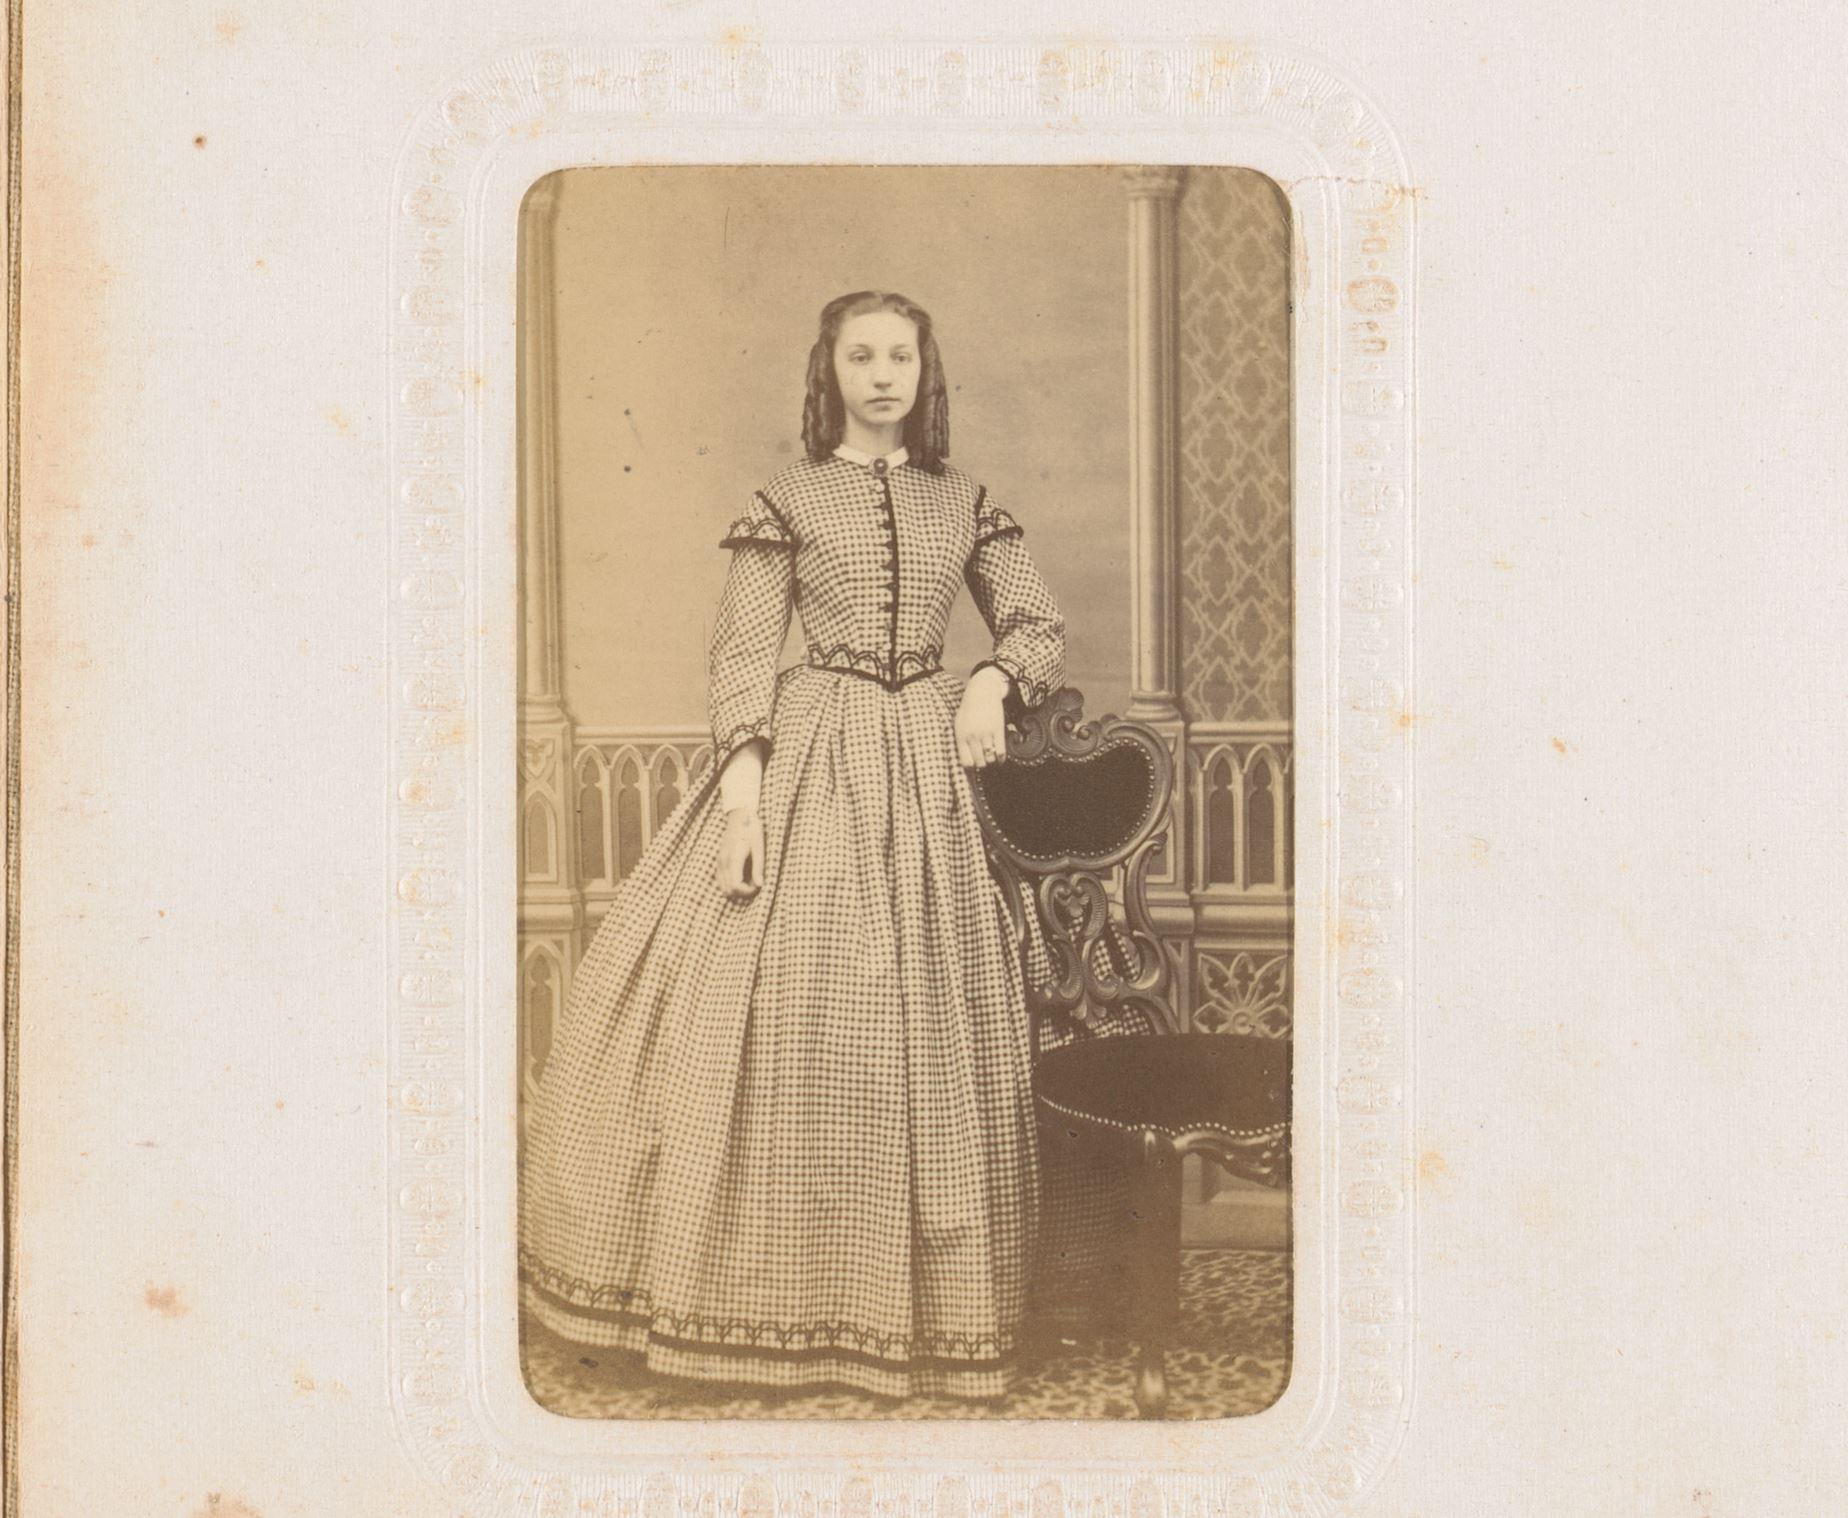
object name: photograph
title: Portret van een jonge vrouw, staand bij een stoel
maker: Anonymous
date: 1860-1900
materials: cardboard, photographic support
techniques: albumen print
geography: netherlands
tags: adolescent, young woman, maiden, historical persons - bb - woman, standing figure - aa - female human figure, chair